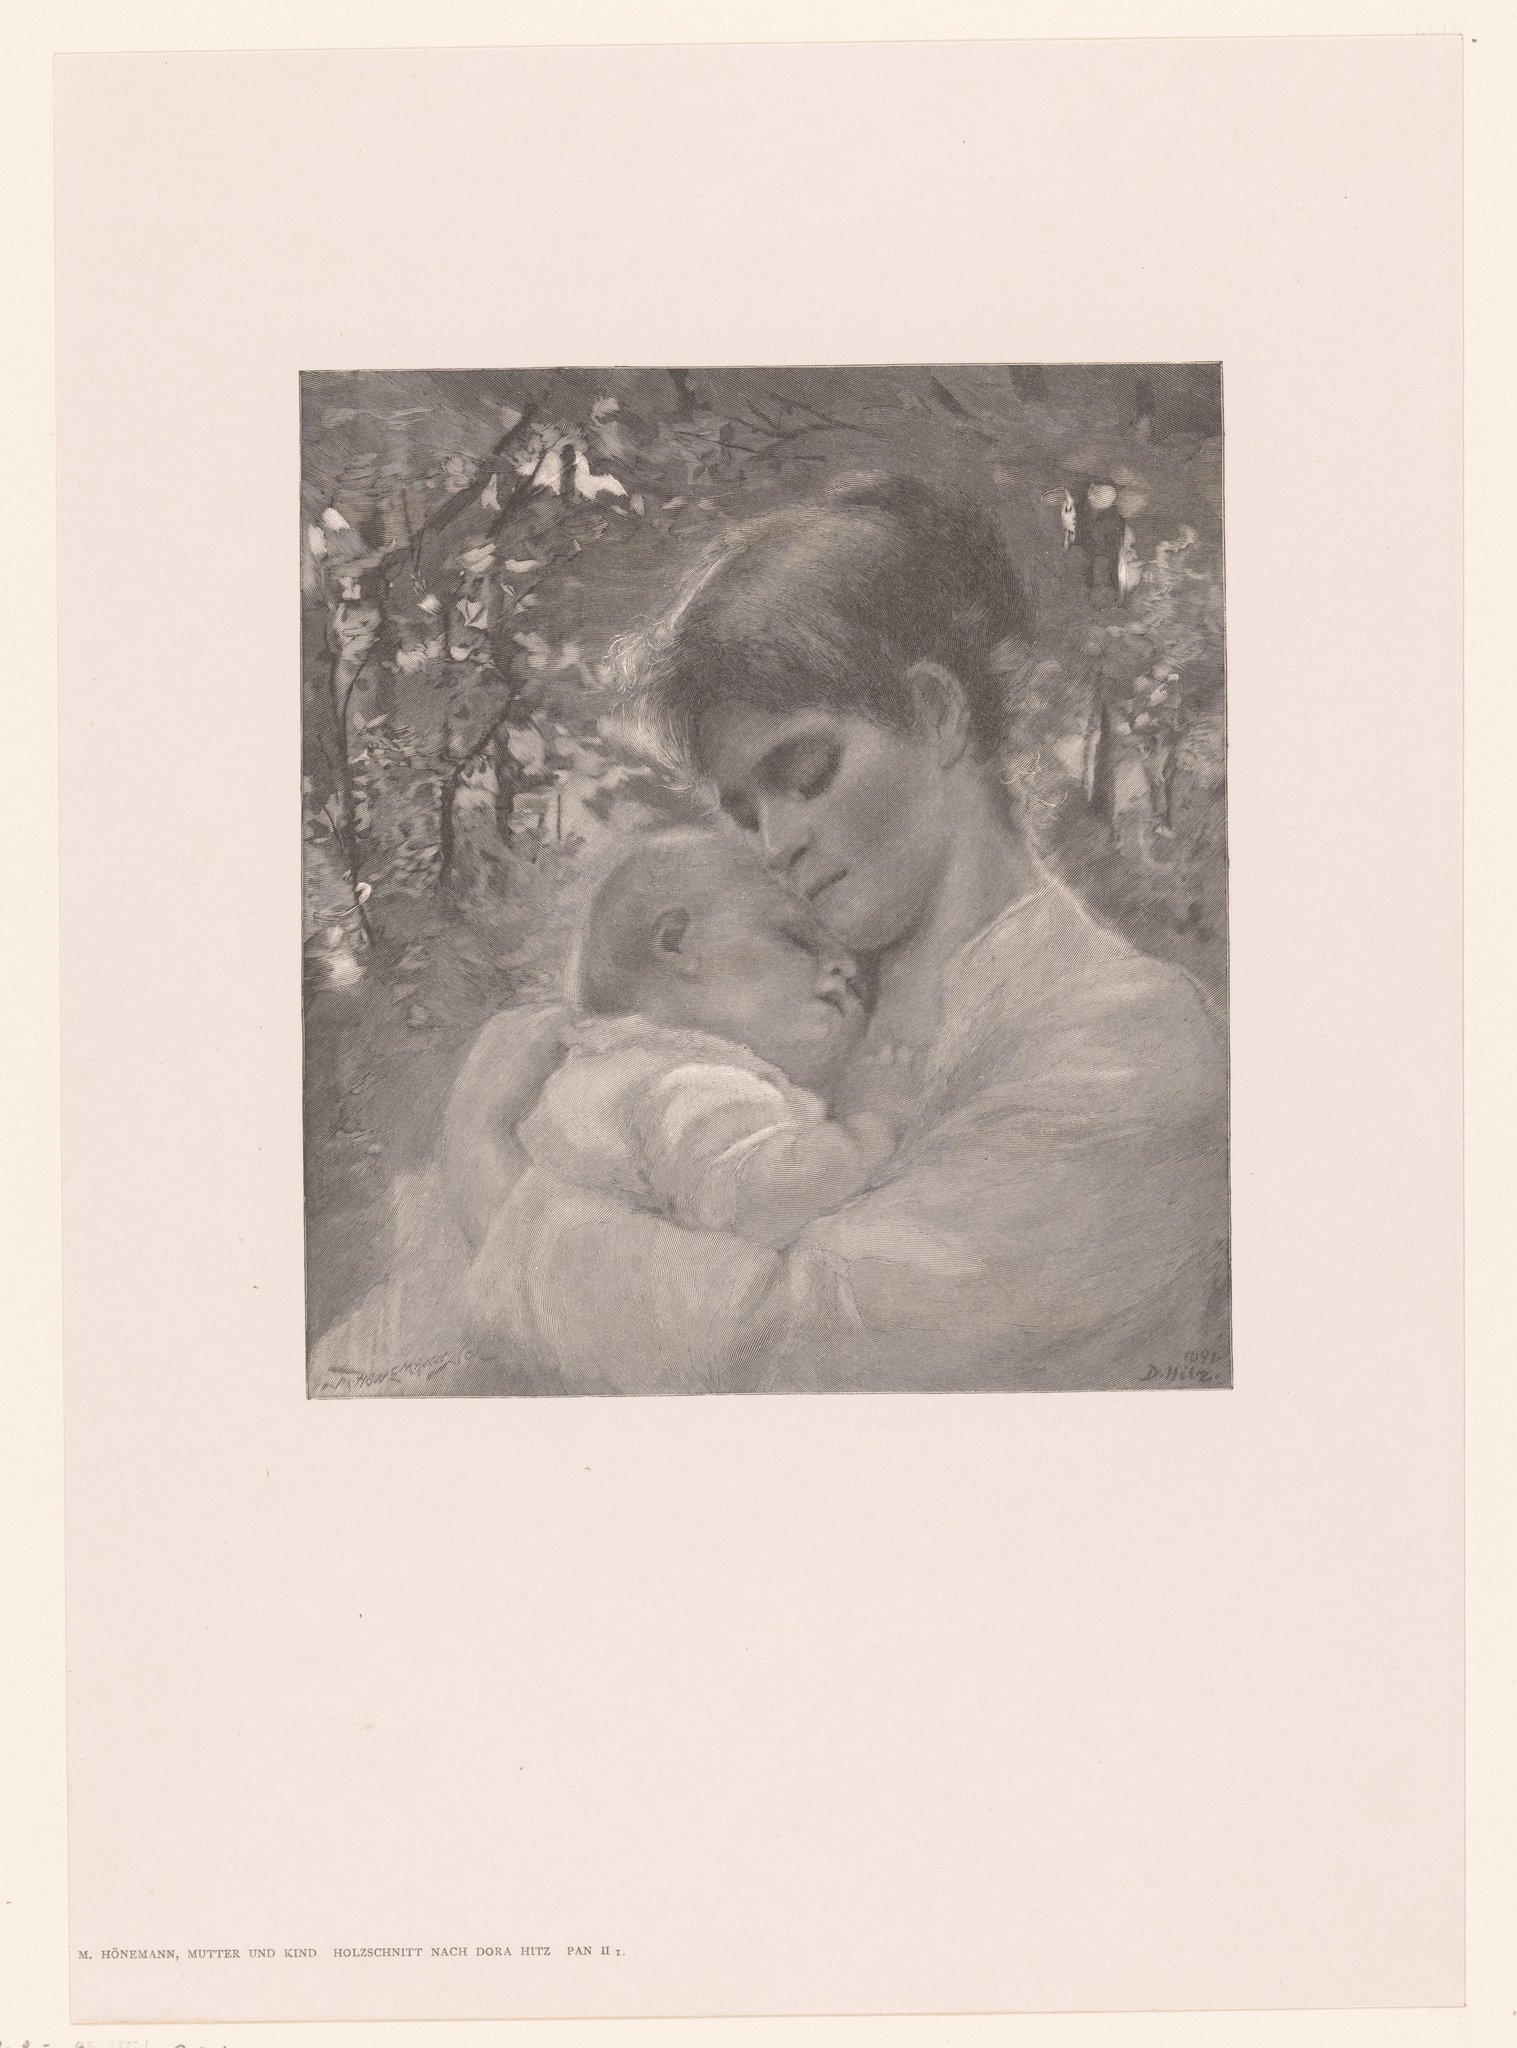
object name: print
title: Mutter und Kind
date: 1891-1900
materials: paper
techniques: engraving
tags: mother and baby or young child